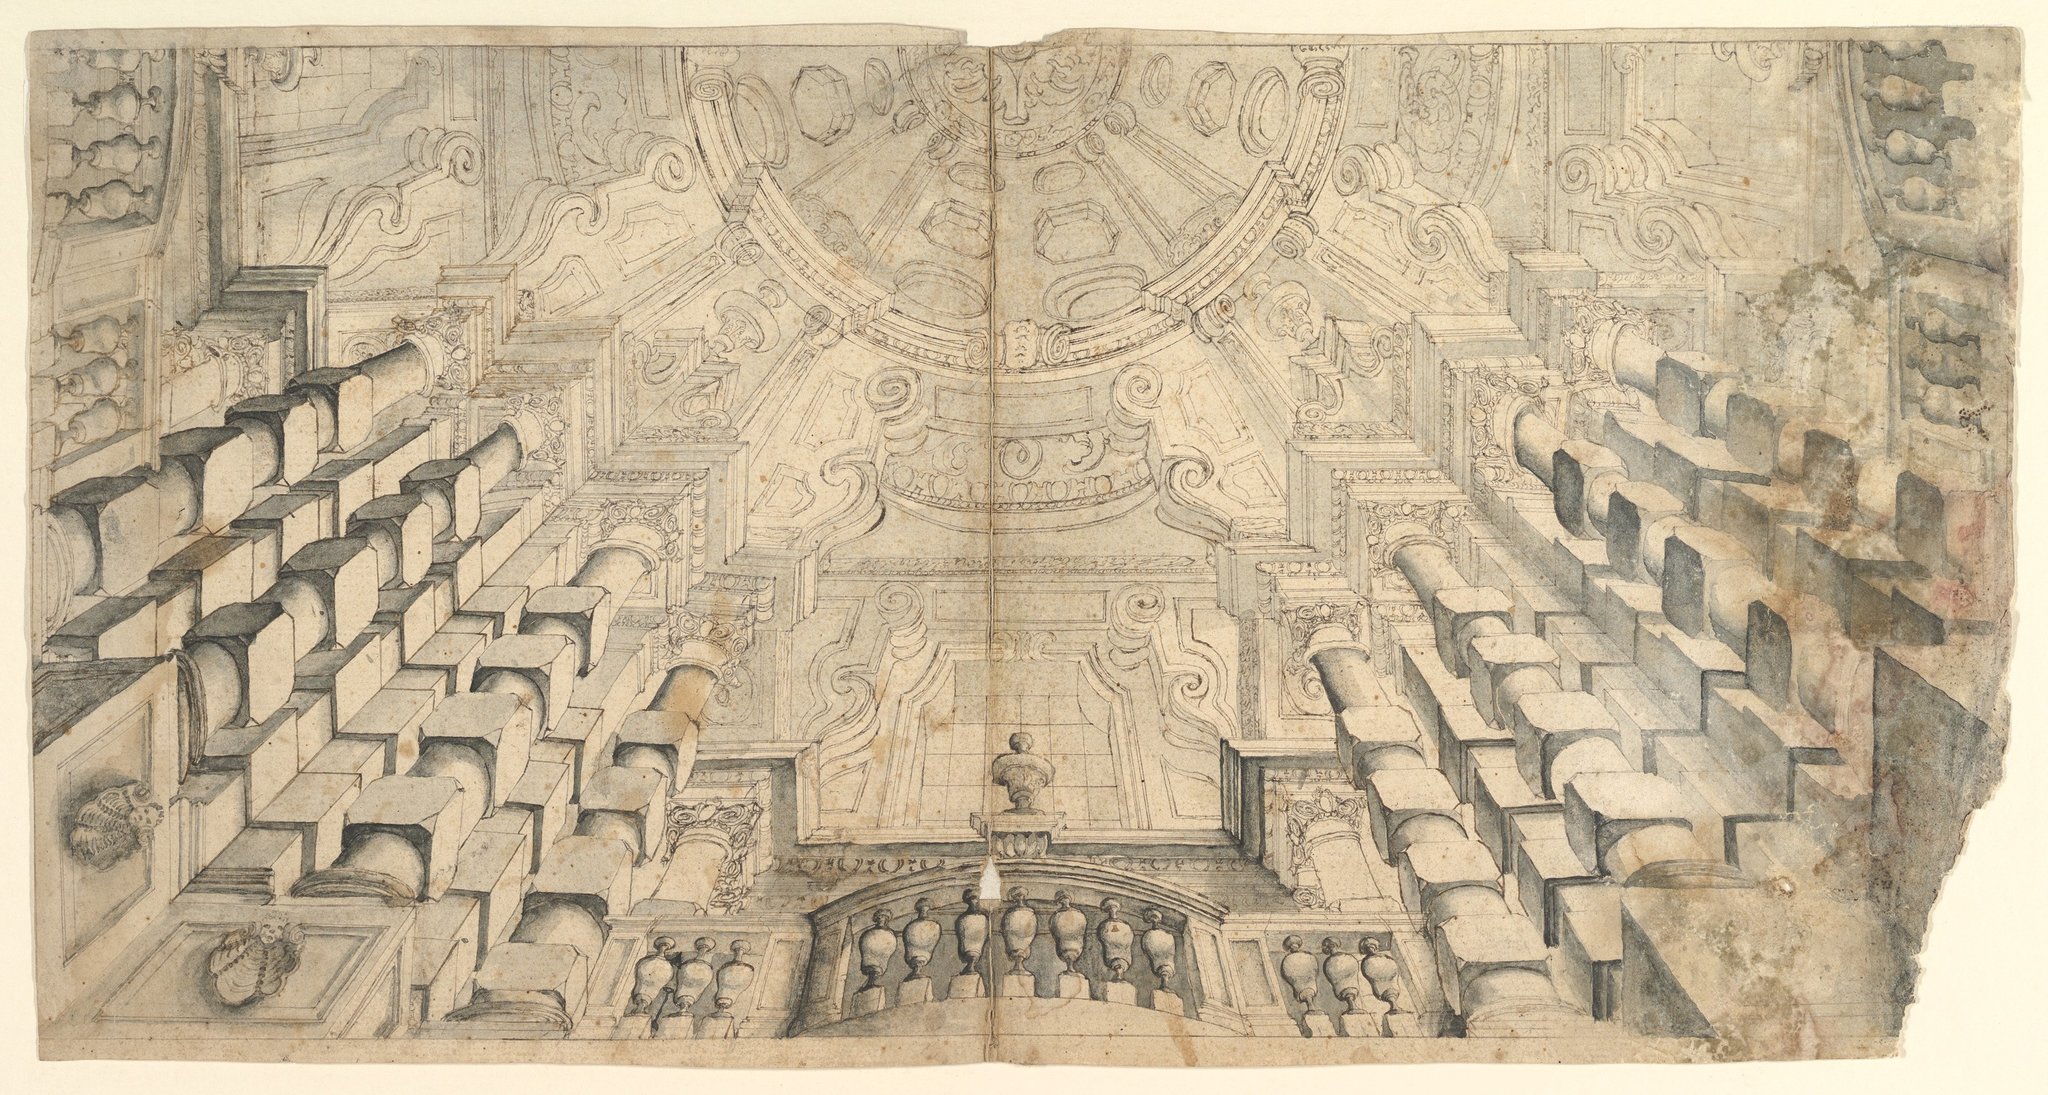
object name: drawing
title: Design for a Ceiling (recto); Studies of an Arcade (verso)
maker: anonymous, italian, 17th century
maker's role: artist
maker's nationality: italian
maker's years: 1600-1700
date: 1601-1700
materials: ink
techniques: brush, pen, wash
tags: architecture